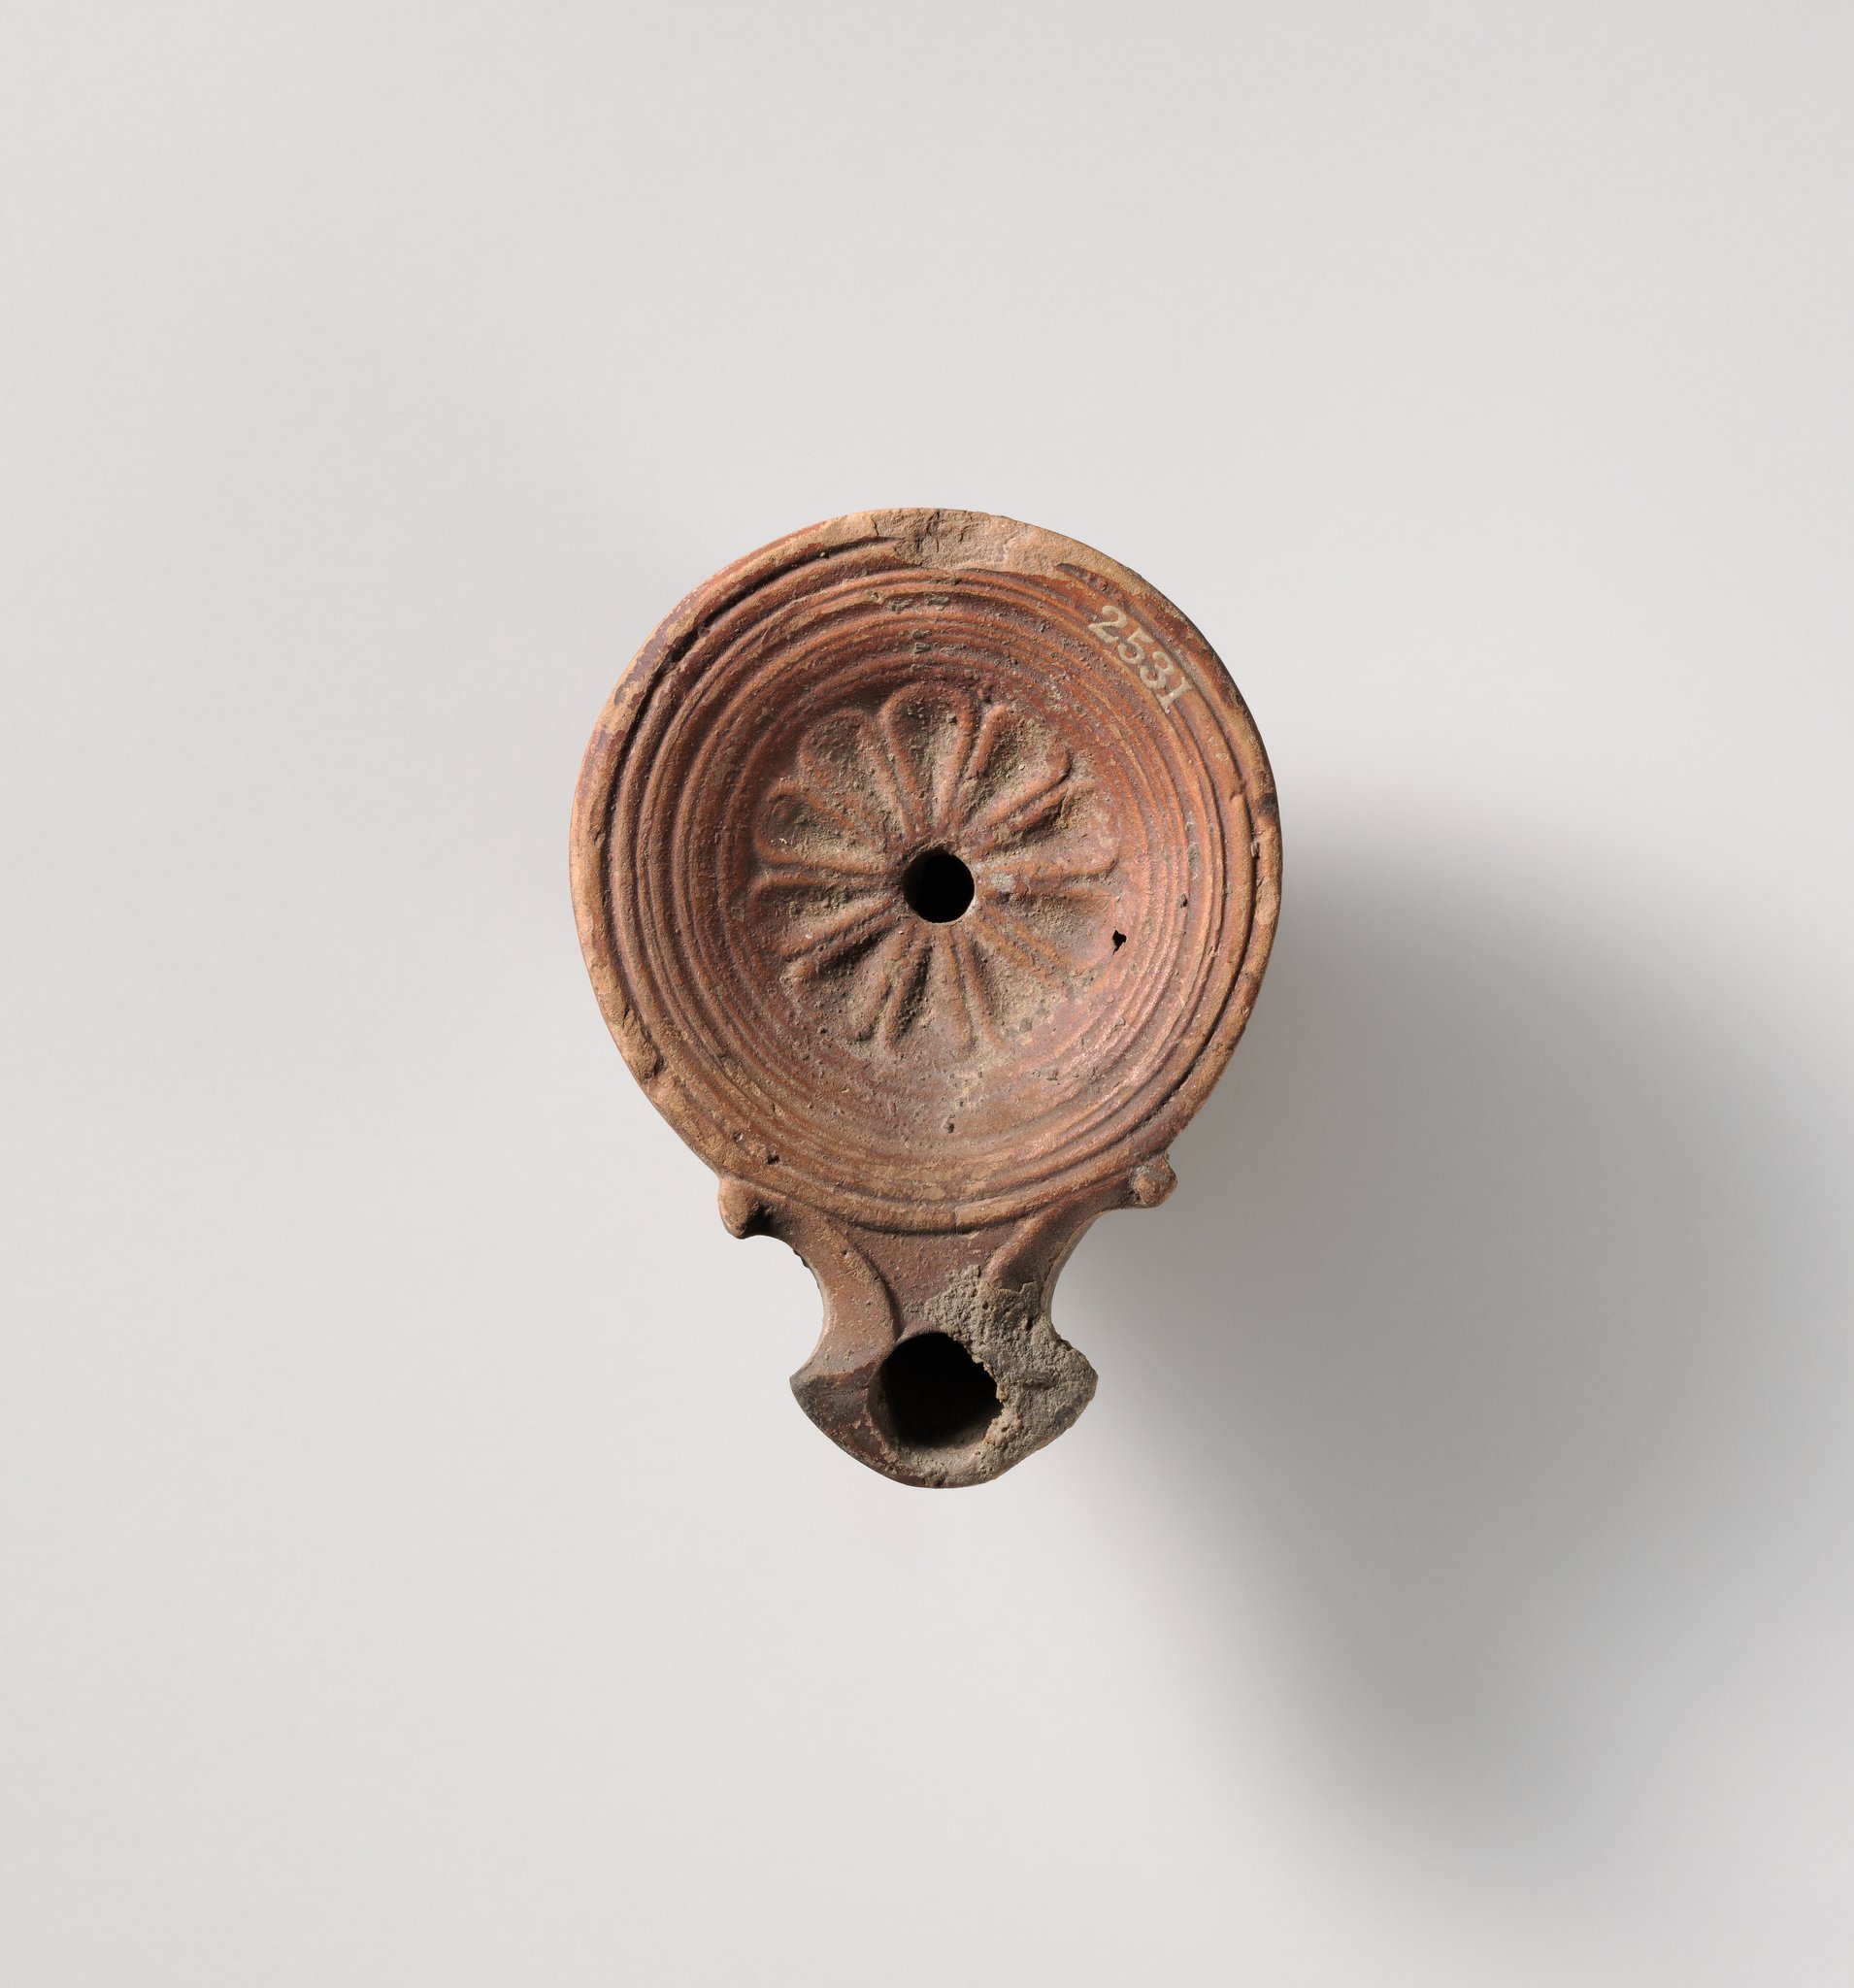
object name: lamp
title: Terracotta oil lamp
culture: roman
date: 100 BCE-100 CE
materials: terracotta